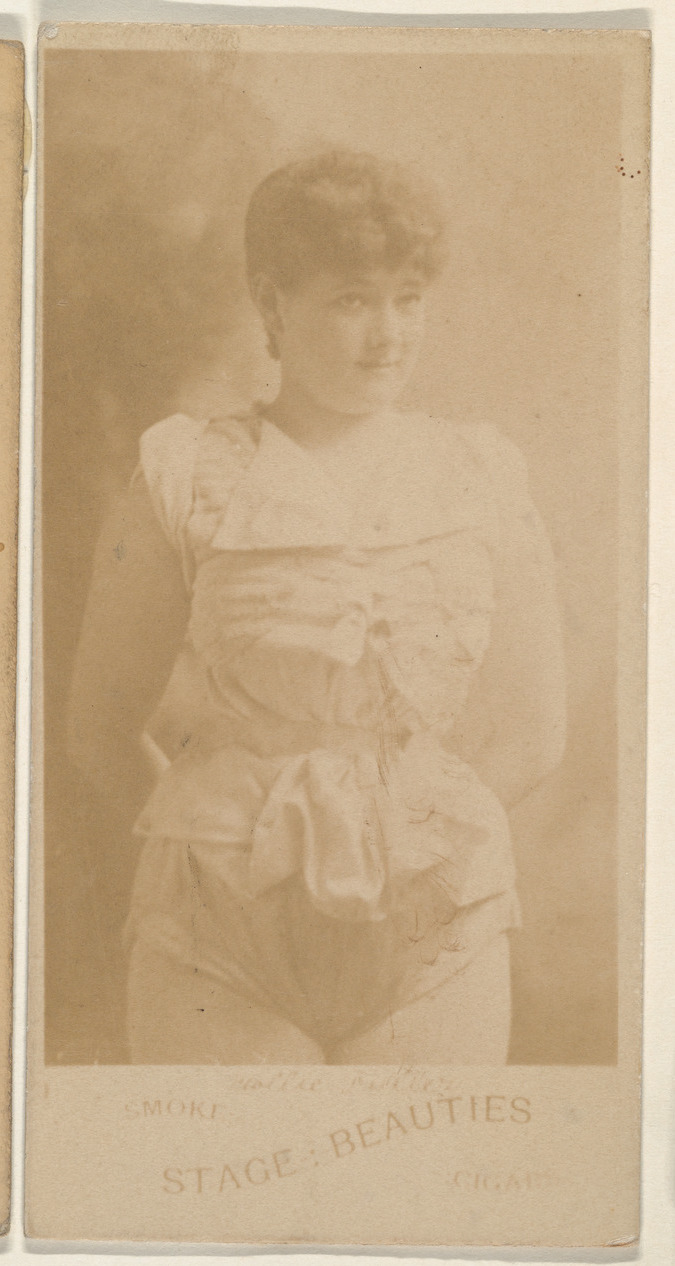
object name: photograph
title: Actress standing with hands behind back, from the Actresses series (N666) to promote Stage Beauties Cigars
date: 1888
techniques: albumen silver print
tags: portraits,women,actresses